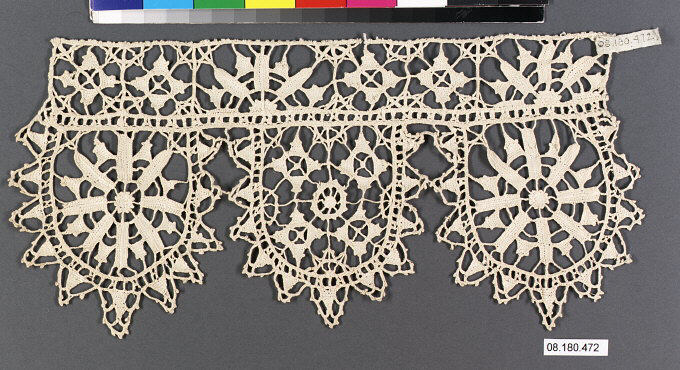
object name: border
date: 1601-1700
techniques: lace